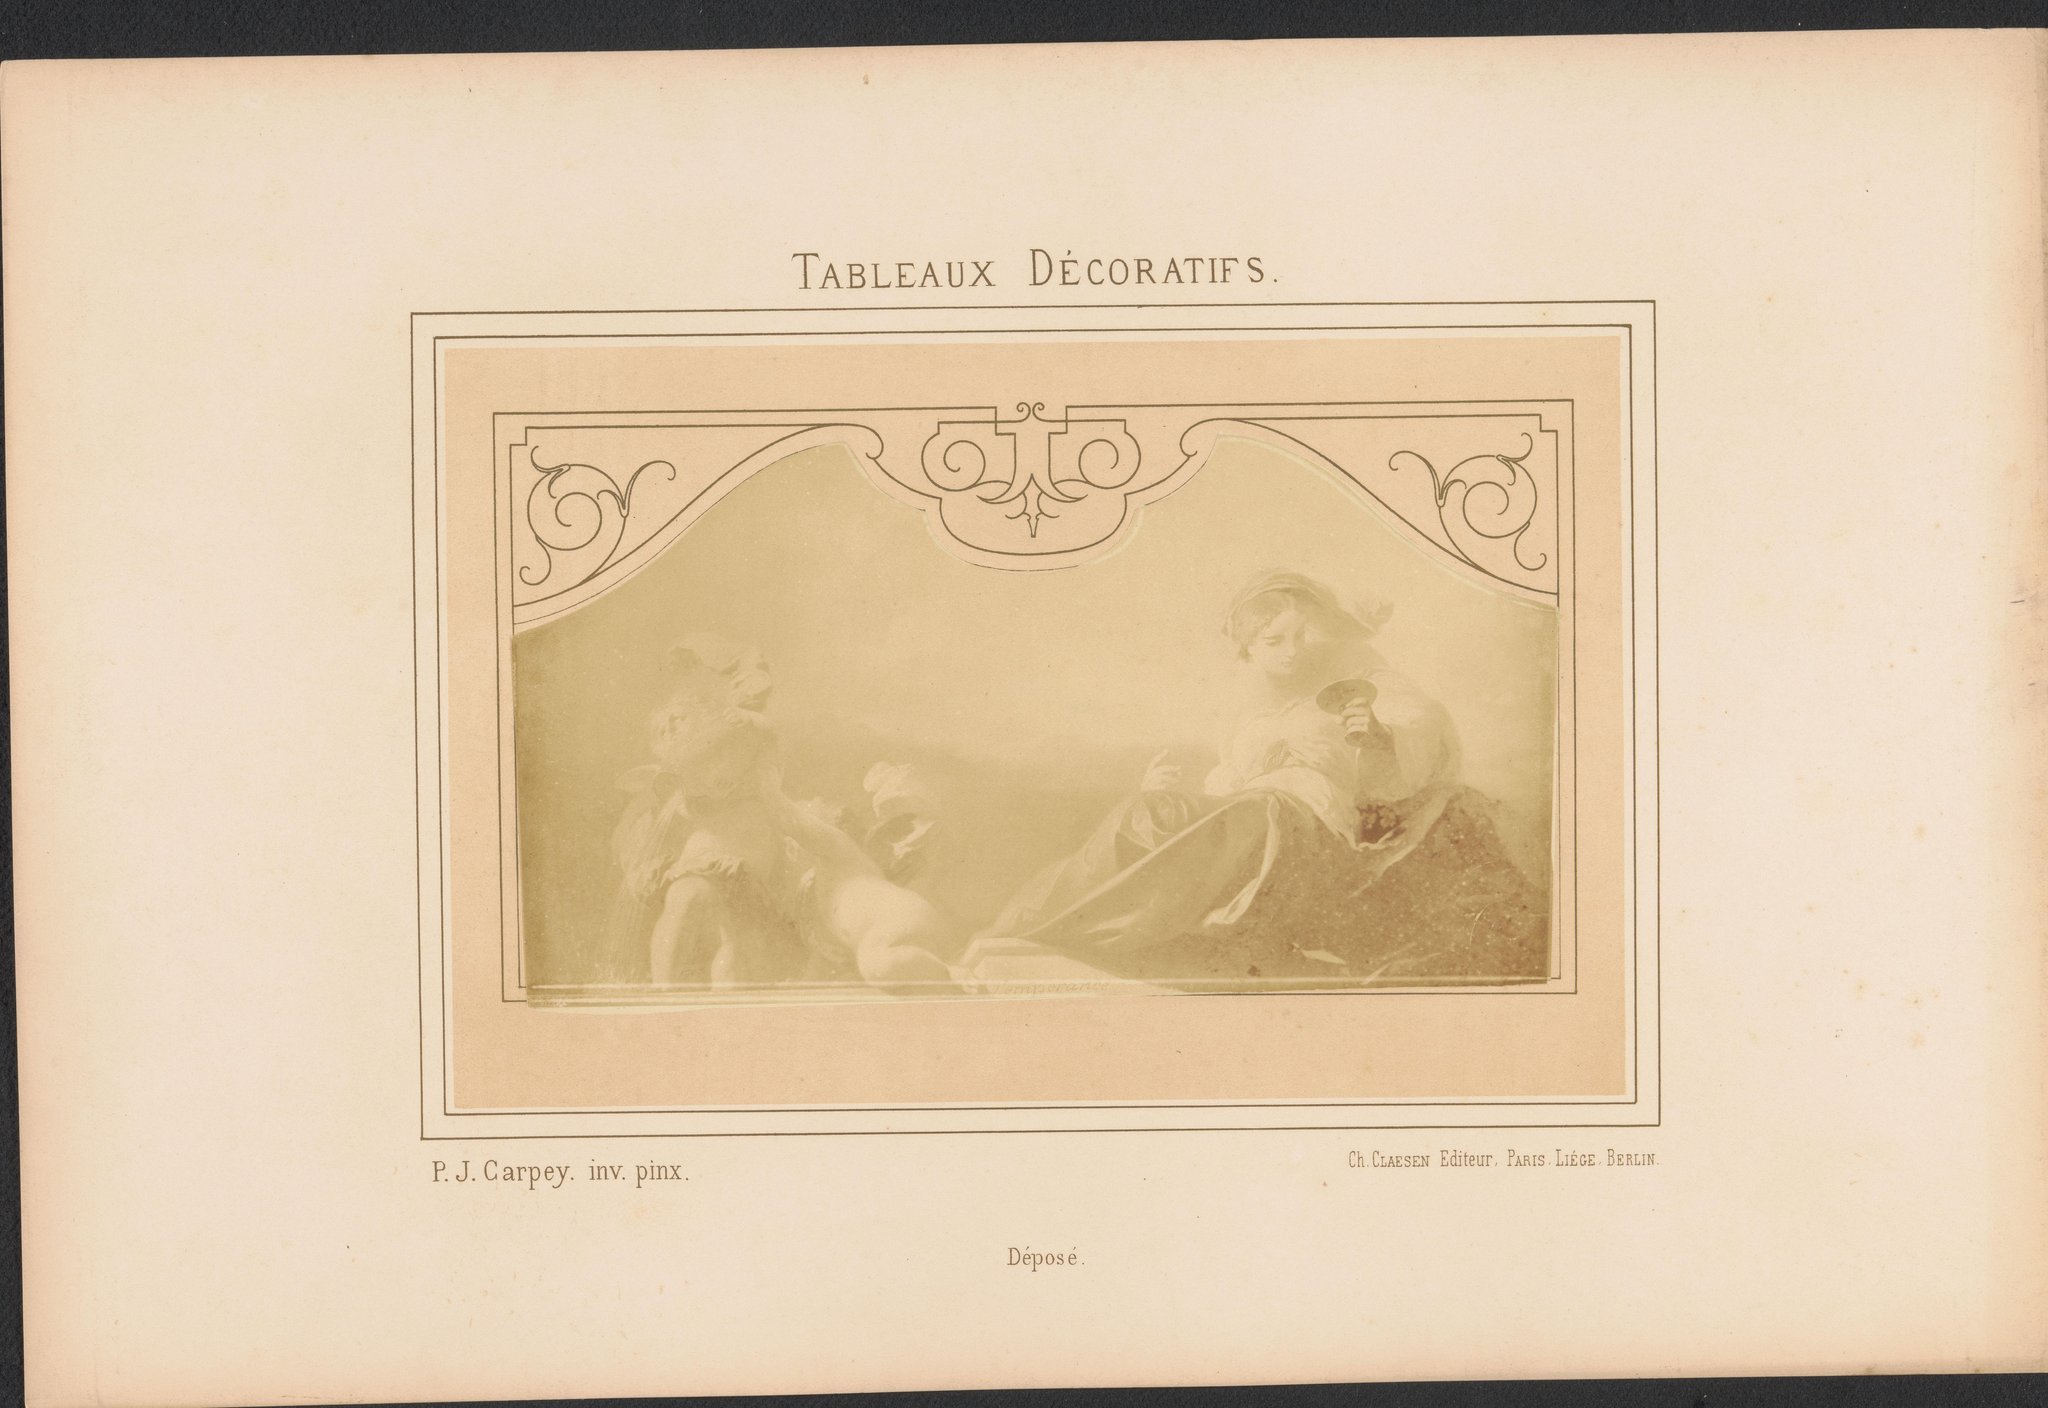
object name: photograph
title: Tableaux Décoratifs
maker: paul-joseph carpay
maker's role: painter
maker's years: 1822-1892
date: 1874-1881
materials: photographic support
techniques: albumen print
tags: adult woman, cupids: 'amores', 'amoretti', 'putti'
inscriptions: inscription: ‘Ch. Claesen Editeur , Paris , Liége & Berlin.’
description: Deze foto maakt deel uit van een omslag met 24 foto's op 22 bladen.